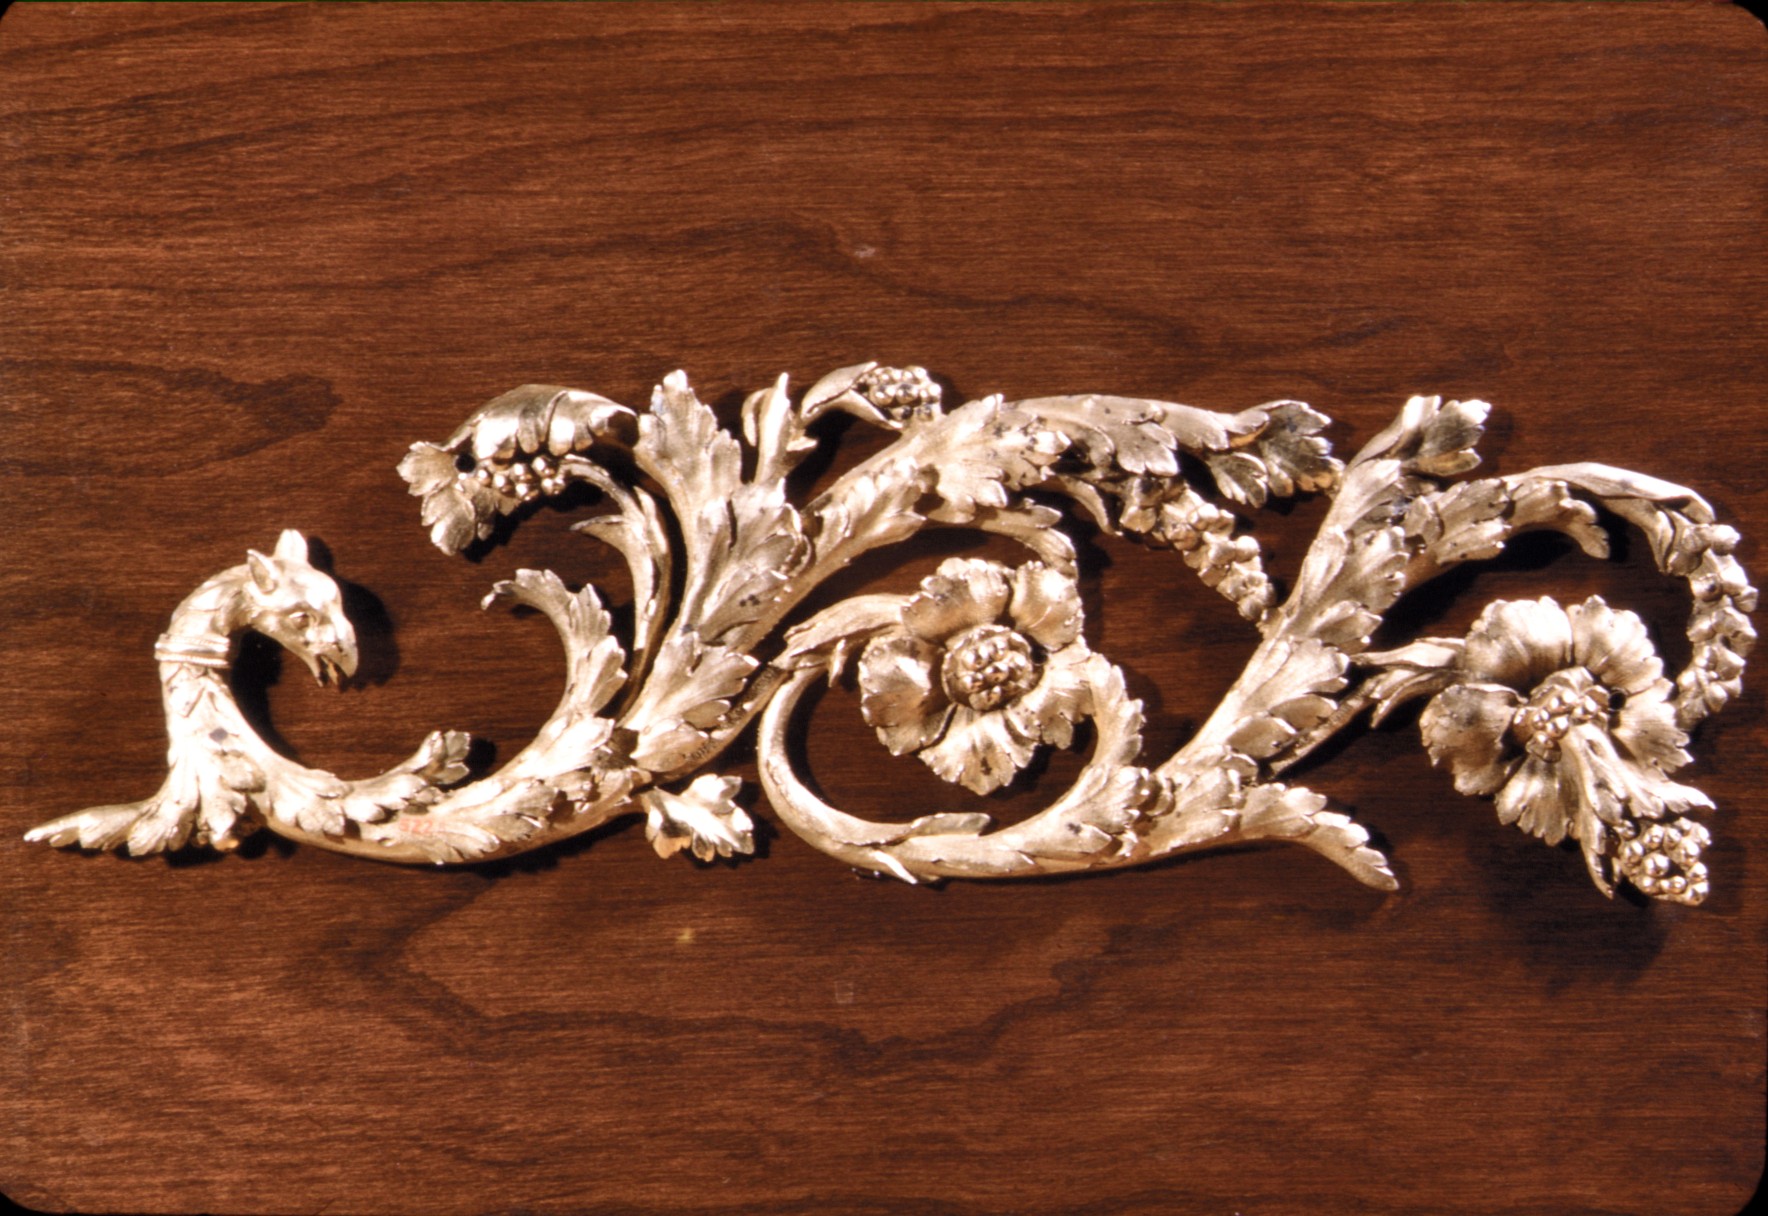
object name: frieze ornament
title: Pair of frieze ornaments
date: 1701-1800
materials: gilt bronze